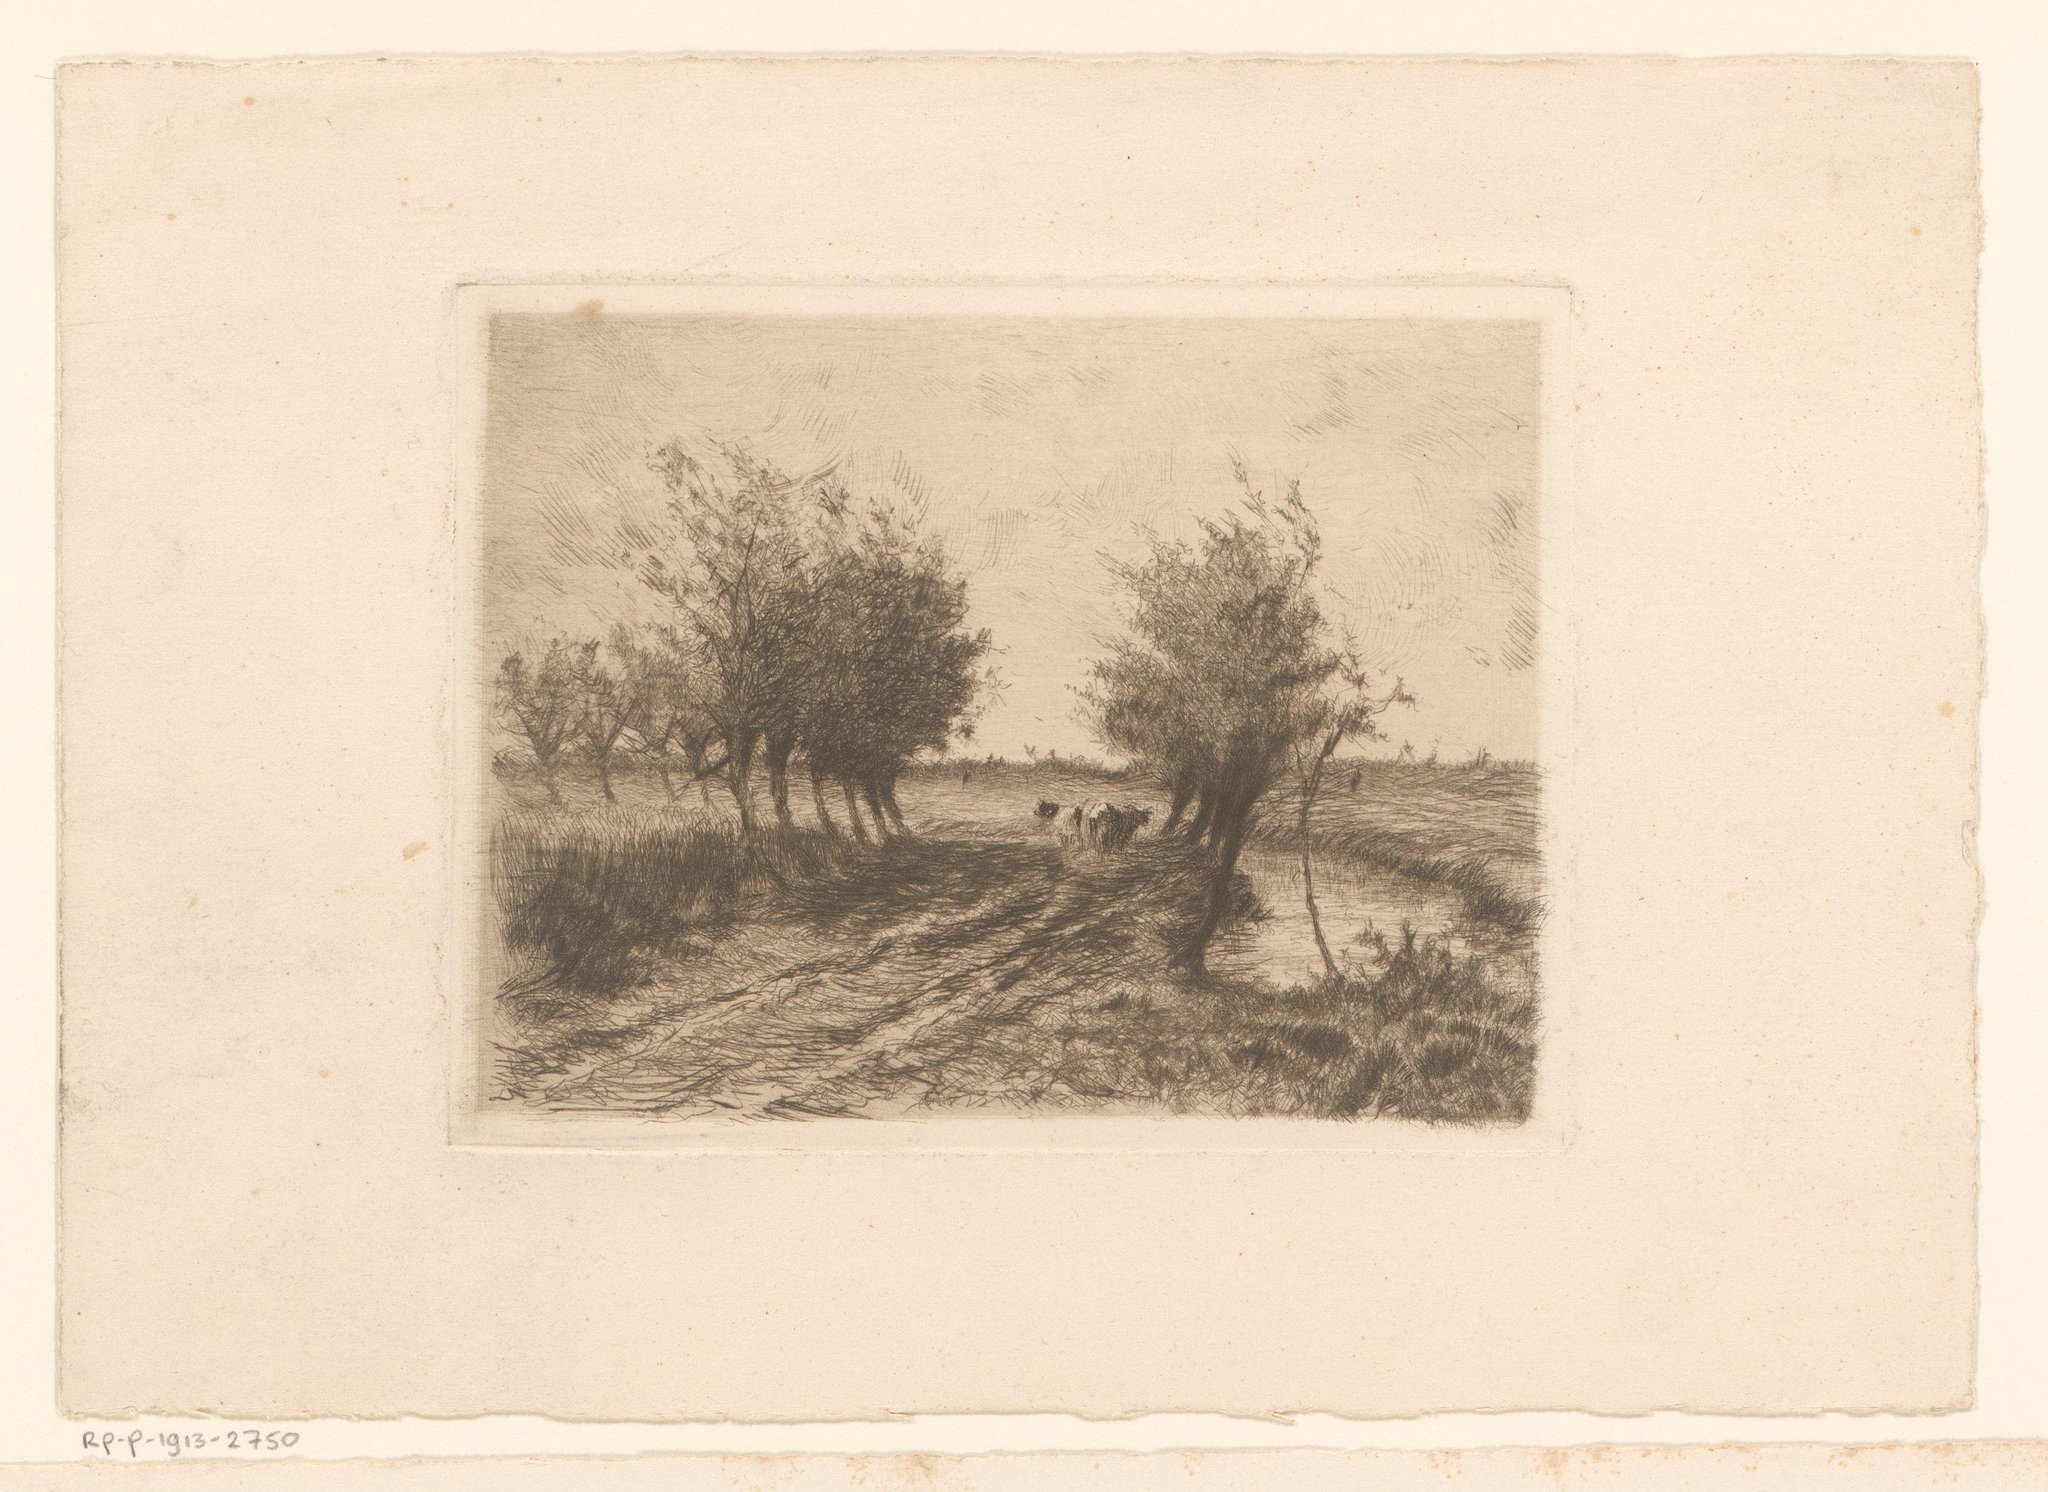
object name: print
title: Landschap met koeien op een weg langs een sloot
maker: henri rul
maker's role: print maker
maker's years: 1862-1942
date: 1872-1913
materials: paper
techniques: drypoint, etching, intaglio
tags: cow, road, path, brook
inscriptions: collector's mark: Lugt 2228